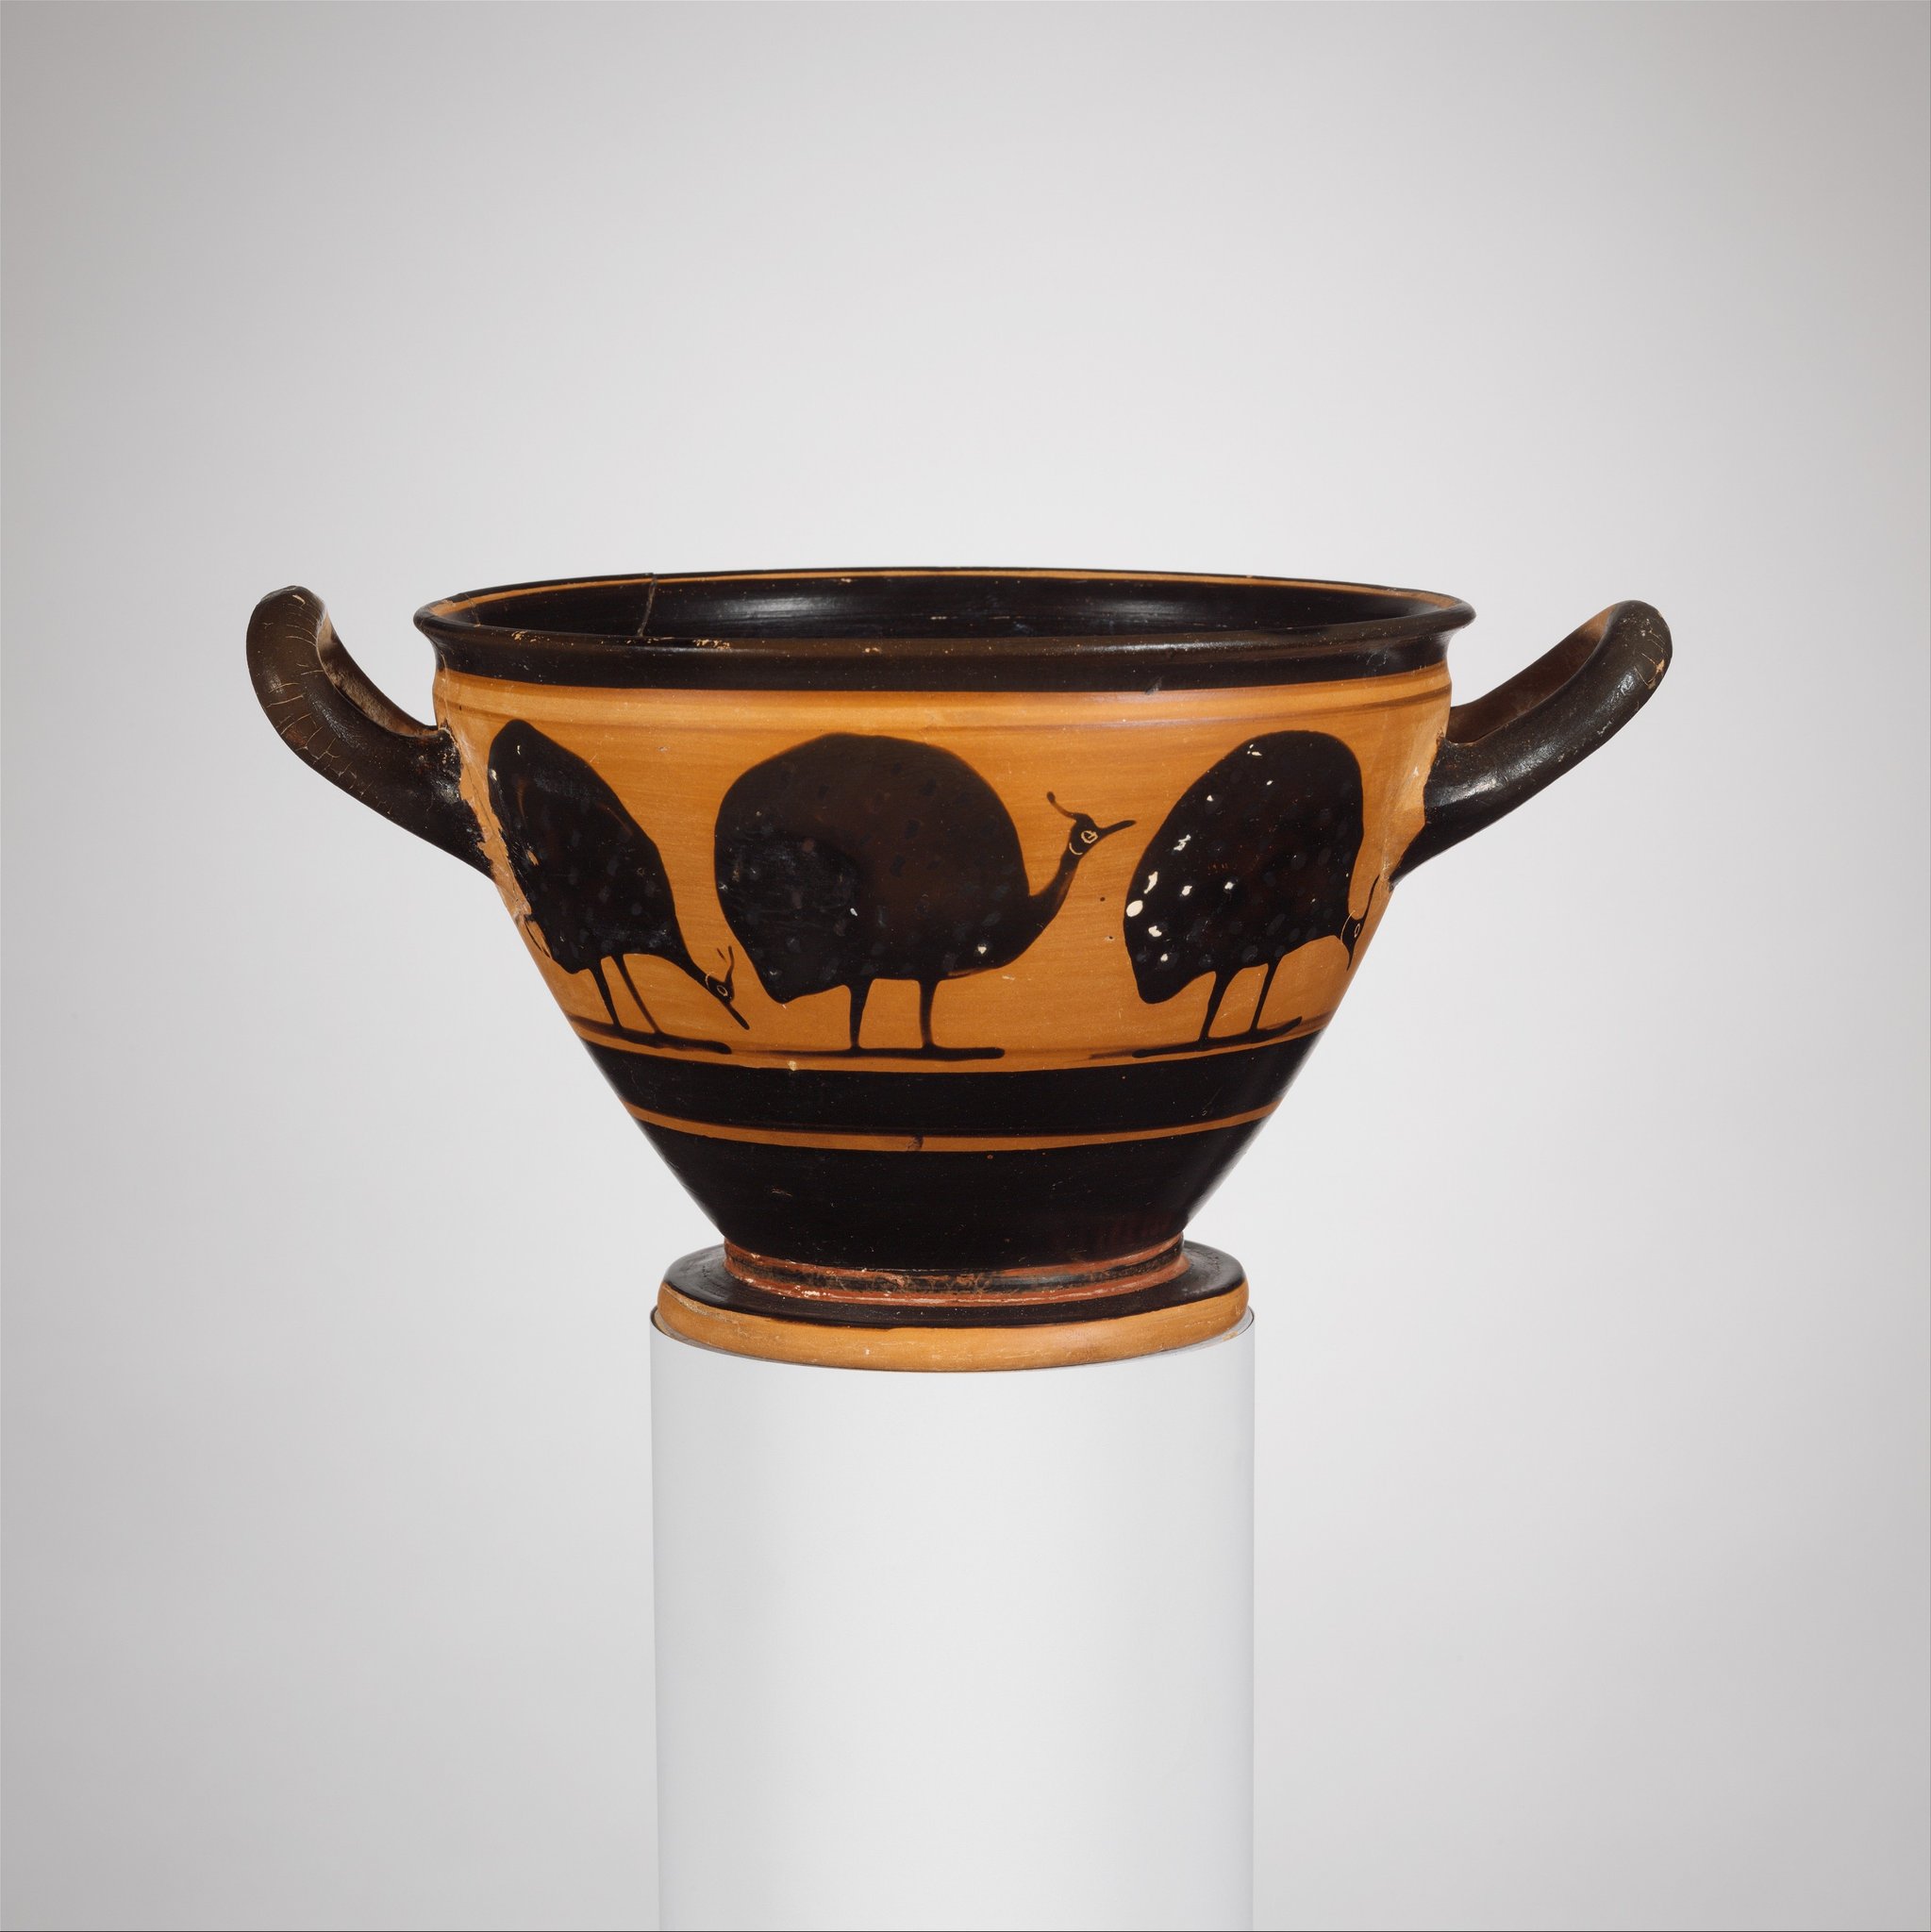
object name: skyphos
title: Terracotta skyphos (deep drinking cup)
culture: greek, attic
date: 500 BCE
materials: terracotta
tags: birds